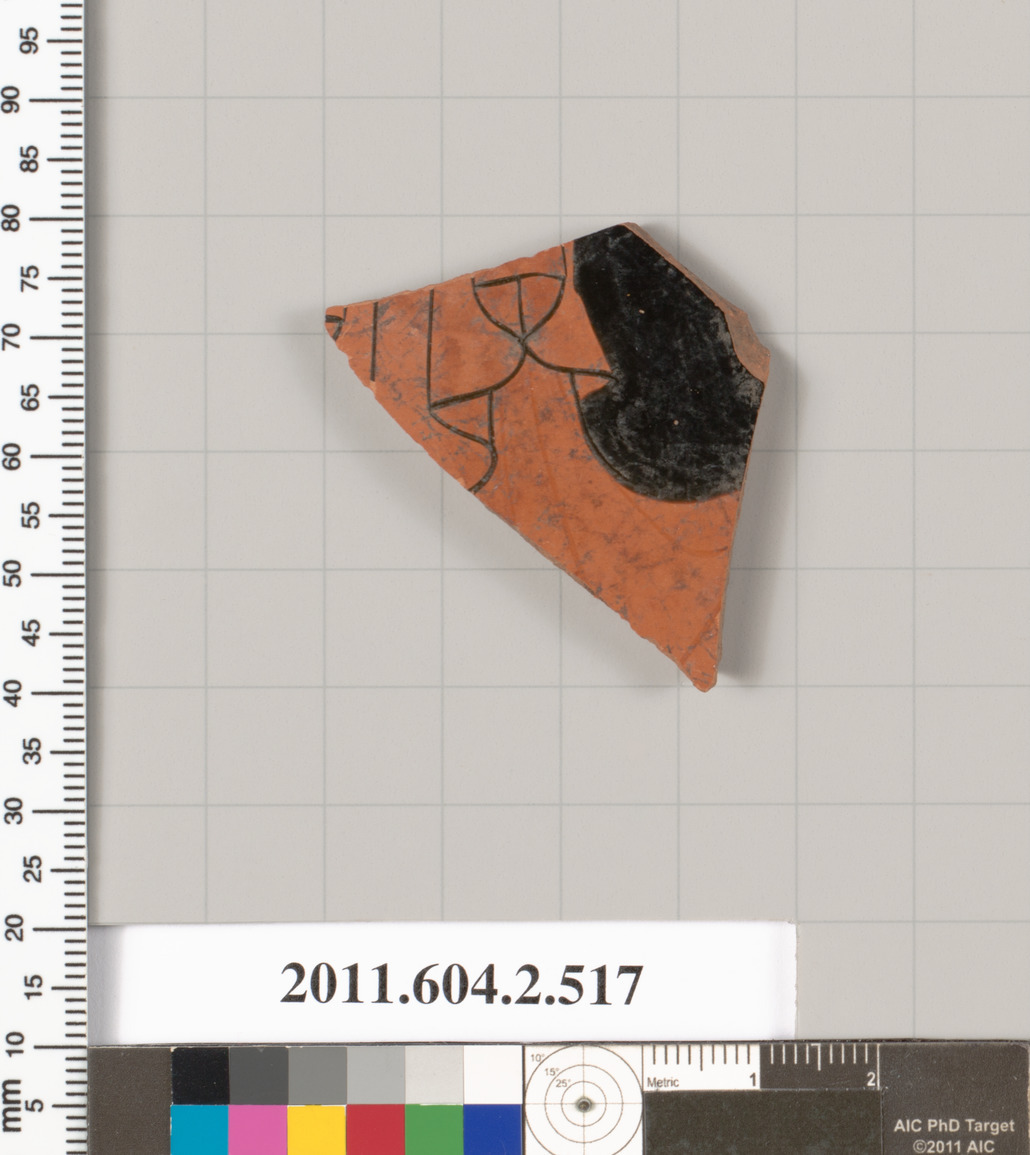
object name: column krater fragment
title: Terracotta fragment of a column-krater (bowl for mixing wine and water)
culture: greek, attic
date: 460-440 BCE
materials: terracotta